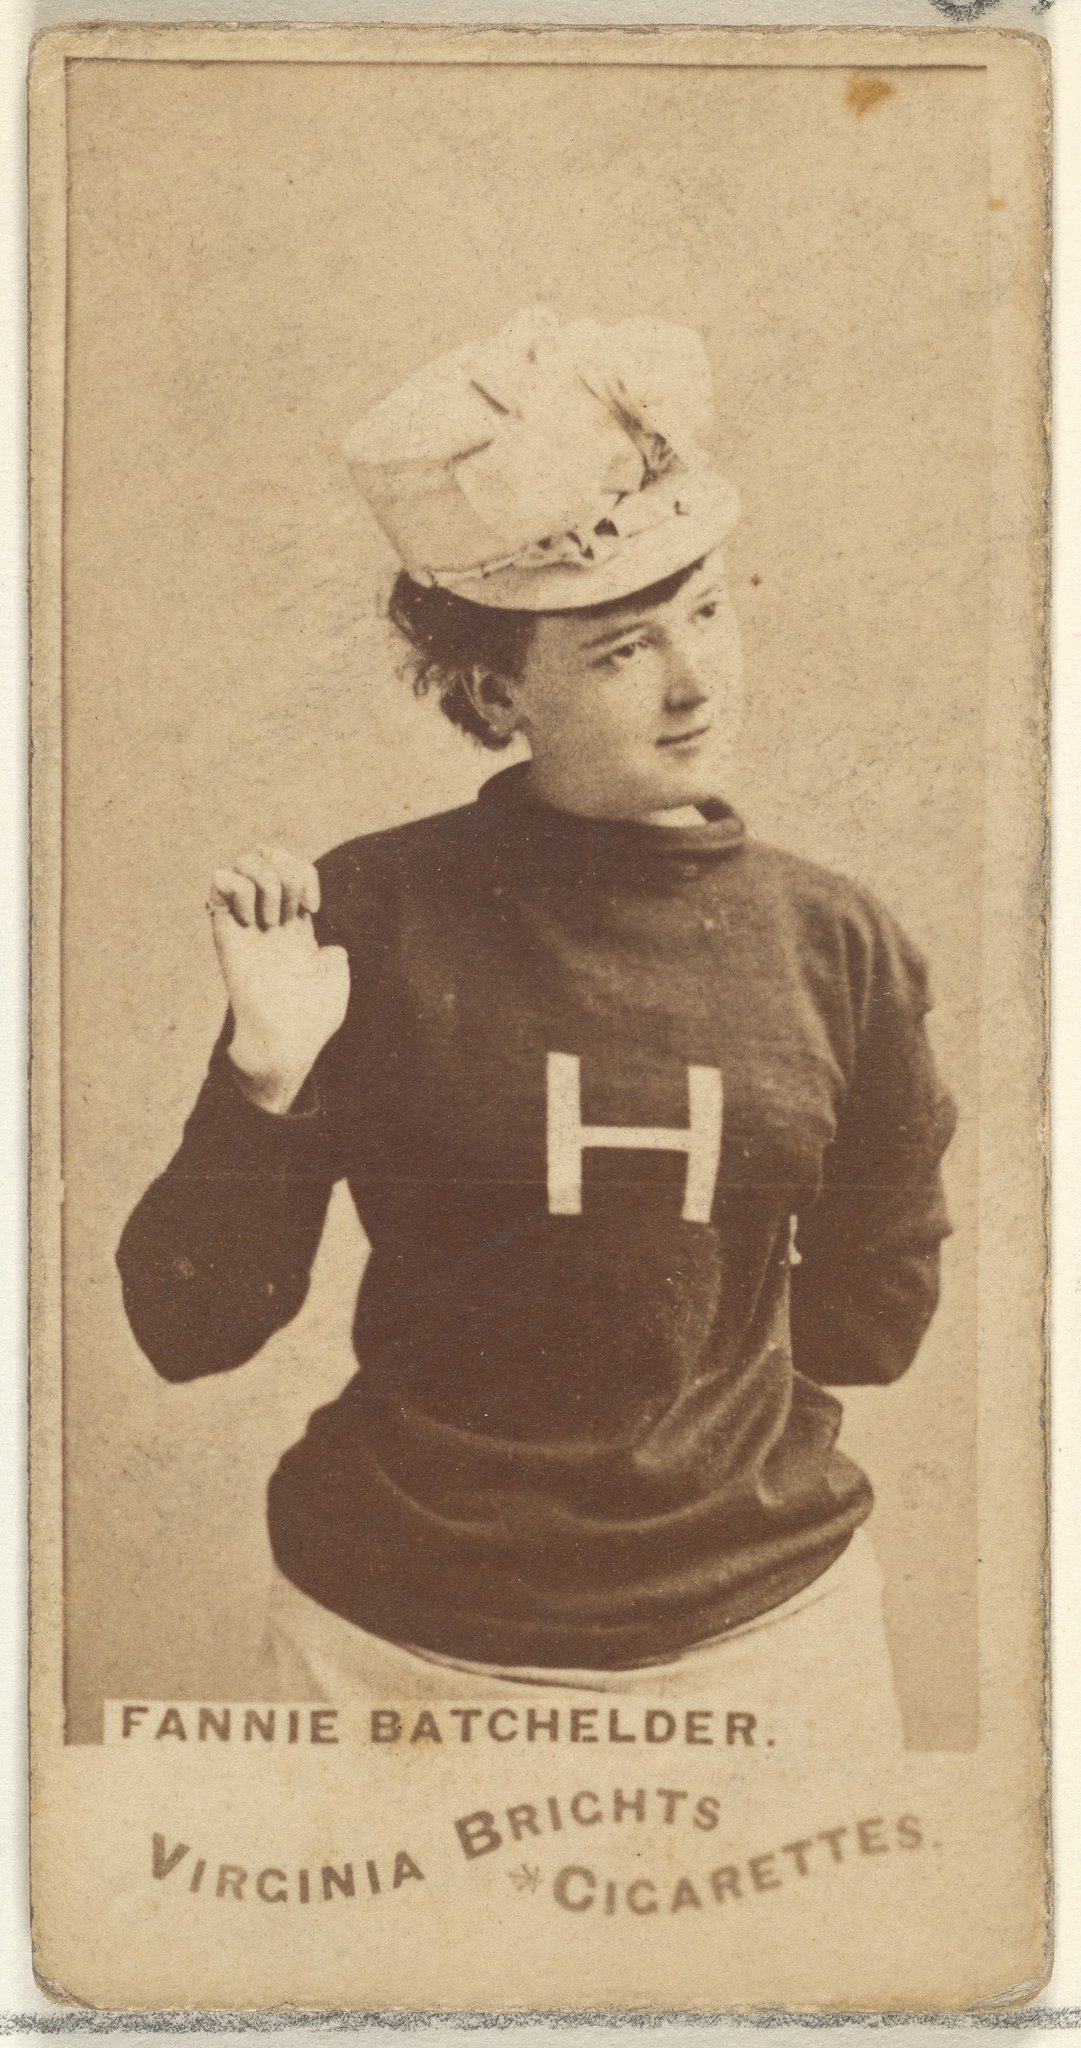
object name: photograph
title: Fannie Batchelder, from the Actors and Actresses series (N45, Type 1) for Virginia Brights Cigarettes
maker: allen & ginter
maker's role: publisher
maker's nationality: american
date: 1888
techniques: albumen silver print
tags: portraits,women,actresses